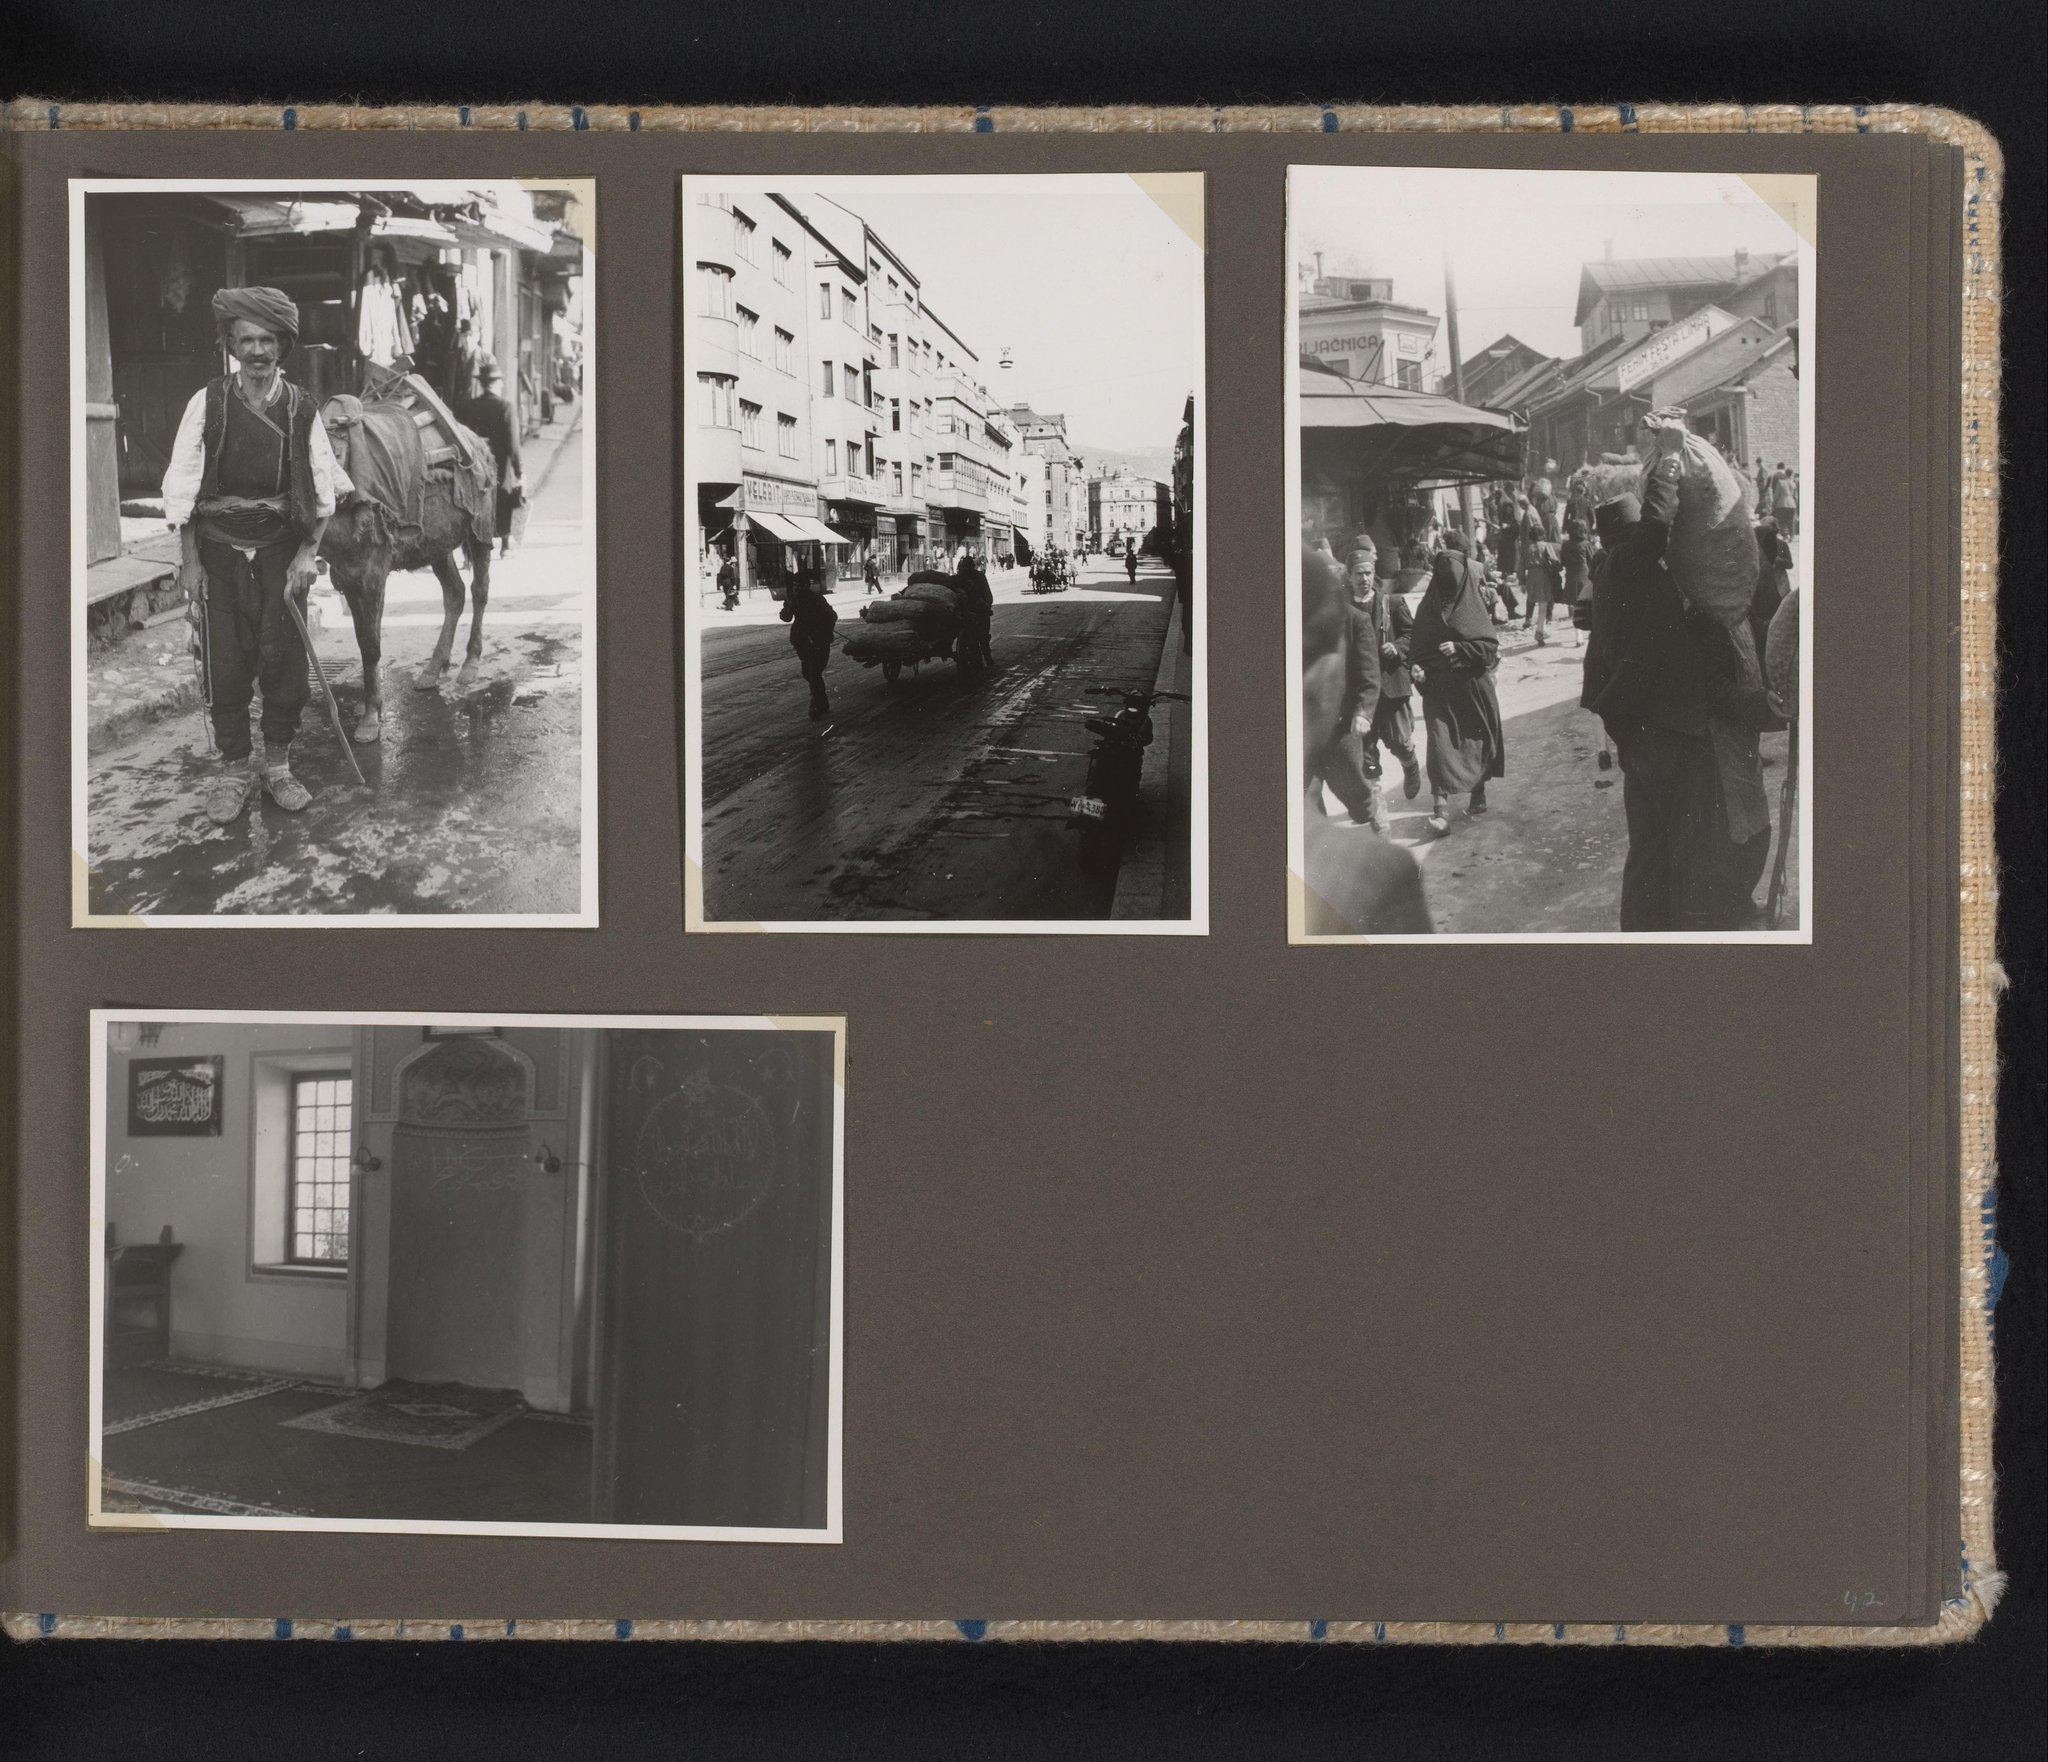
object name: album leaf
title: Sarajevo in Joegoslavië, april 1943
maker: Anonymous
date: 1904-1943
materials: cardboard, photographic support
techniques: gelatin silver print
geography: sarajevo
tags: city-view in general; 'veduta', temple, shrine ~ islam, mohammedanism, market, occupation ~ war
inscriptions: inscription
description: Albumblad met vier foto's gemaakt in Sarajevo in Joegoslavië, april 1943: straatbeelden en interieur van moskee of gebedshuis. Onderdeel van het fotoalbum Abrechnungsintendantur van de Wehrmacht 1941-1943.